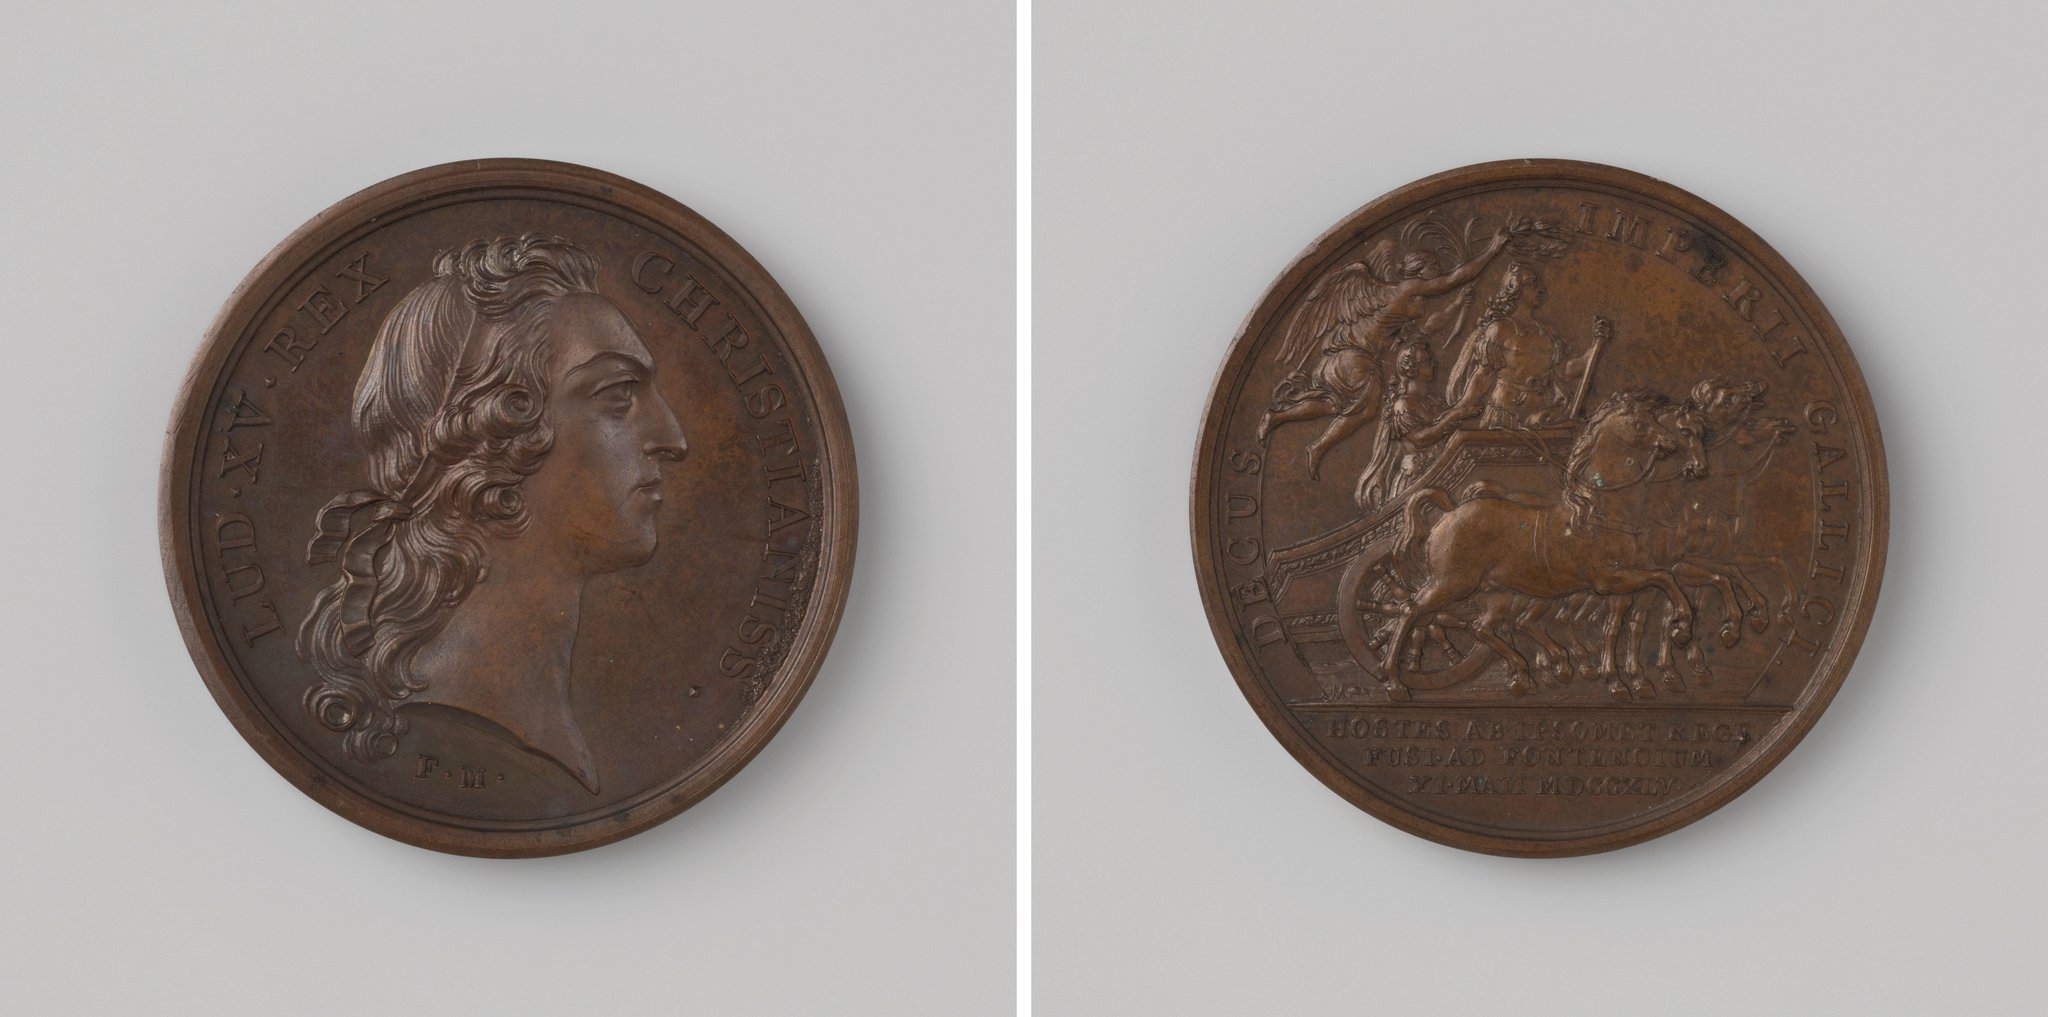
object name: history medal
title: Slag bij Fontenoy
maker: francois joseph marteau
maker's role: medailleur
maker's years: -1757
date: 1745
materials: bronze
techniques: striking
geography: paris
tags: louis xv of france, henegouwen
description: Bronzen penning. Voorzijde: borststuk man binnen omschrift. Keerzijde: koning, afgebeeld als Romeins veldheer, met commandostaf in hand, staat met de Dauphin op een vierspan, terwijl vliegende Overwinning met palmtak hem een lauwerkrans boven hoofd houdt binnen omschrift; afsnede: opschrift